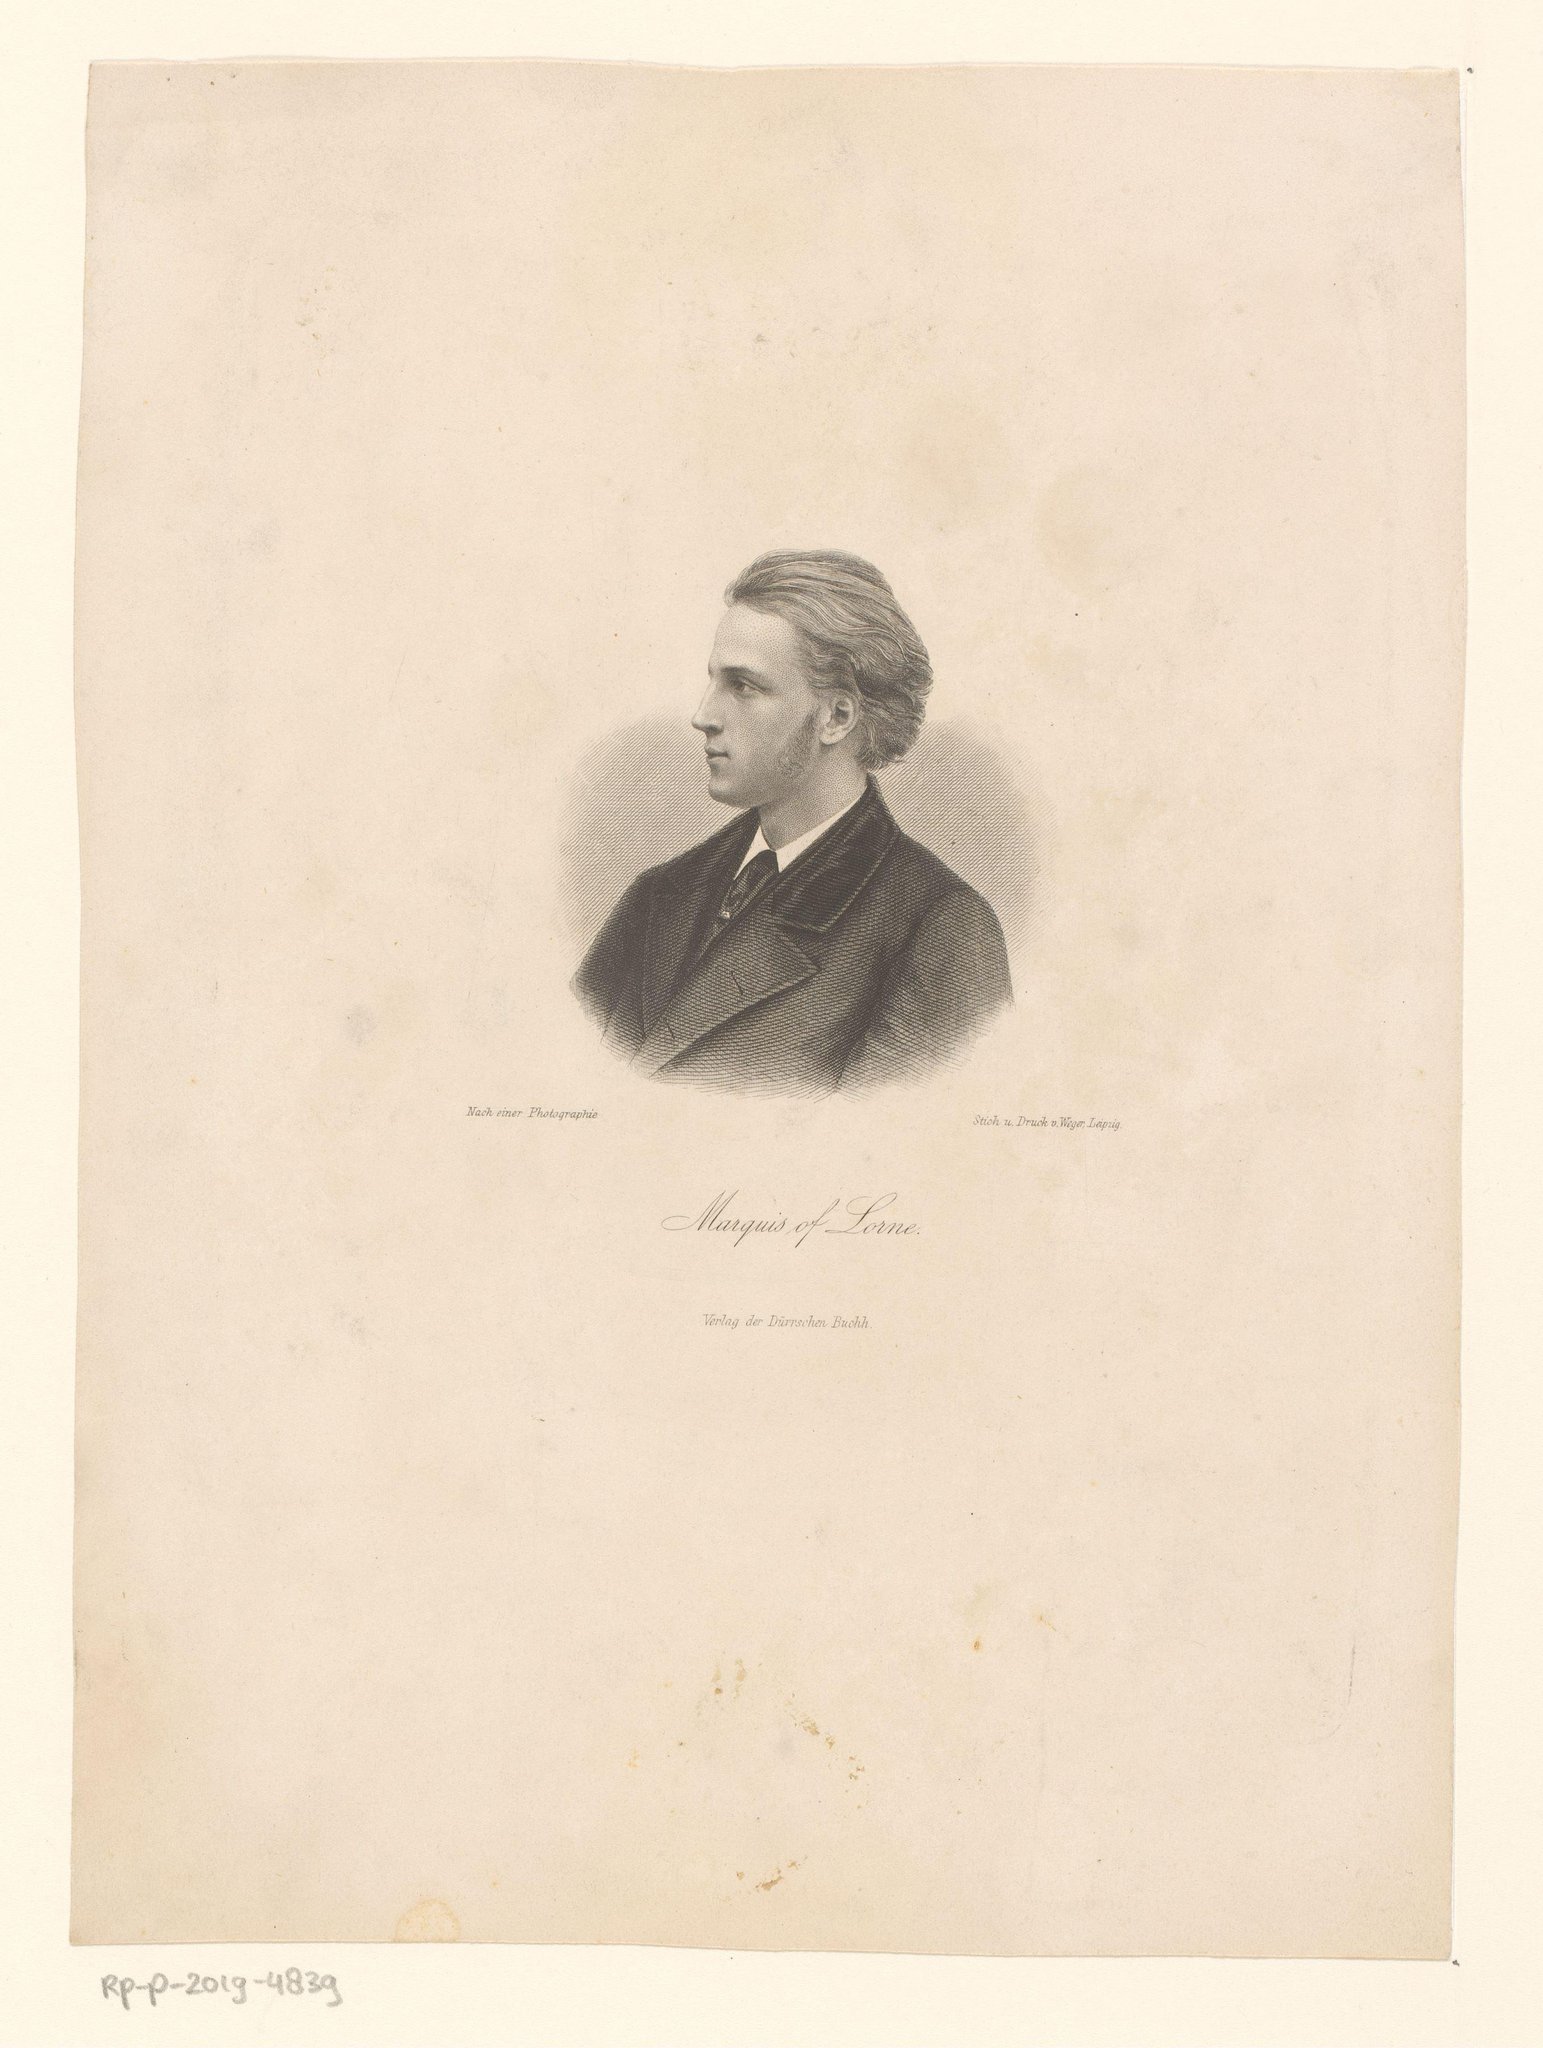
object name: print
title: Portret van John Campbell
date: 1878-1892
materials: paper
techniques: etching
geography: leipzig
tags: london, john campbell (9th duke of argyll), historical persons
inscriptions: collector's mark: Lugt 2228, collector's mark: Lugt 2760